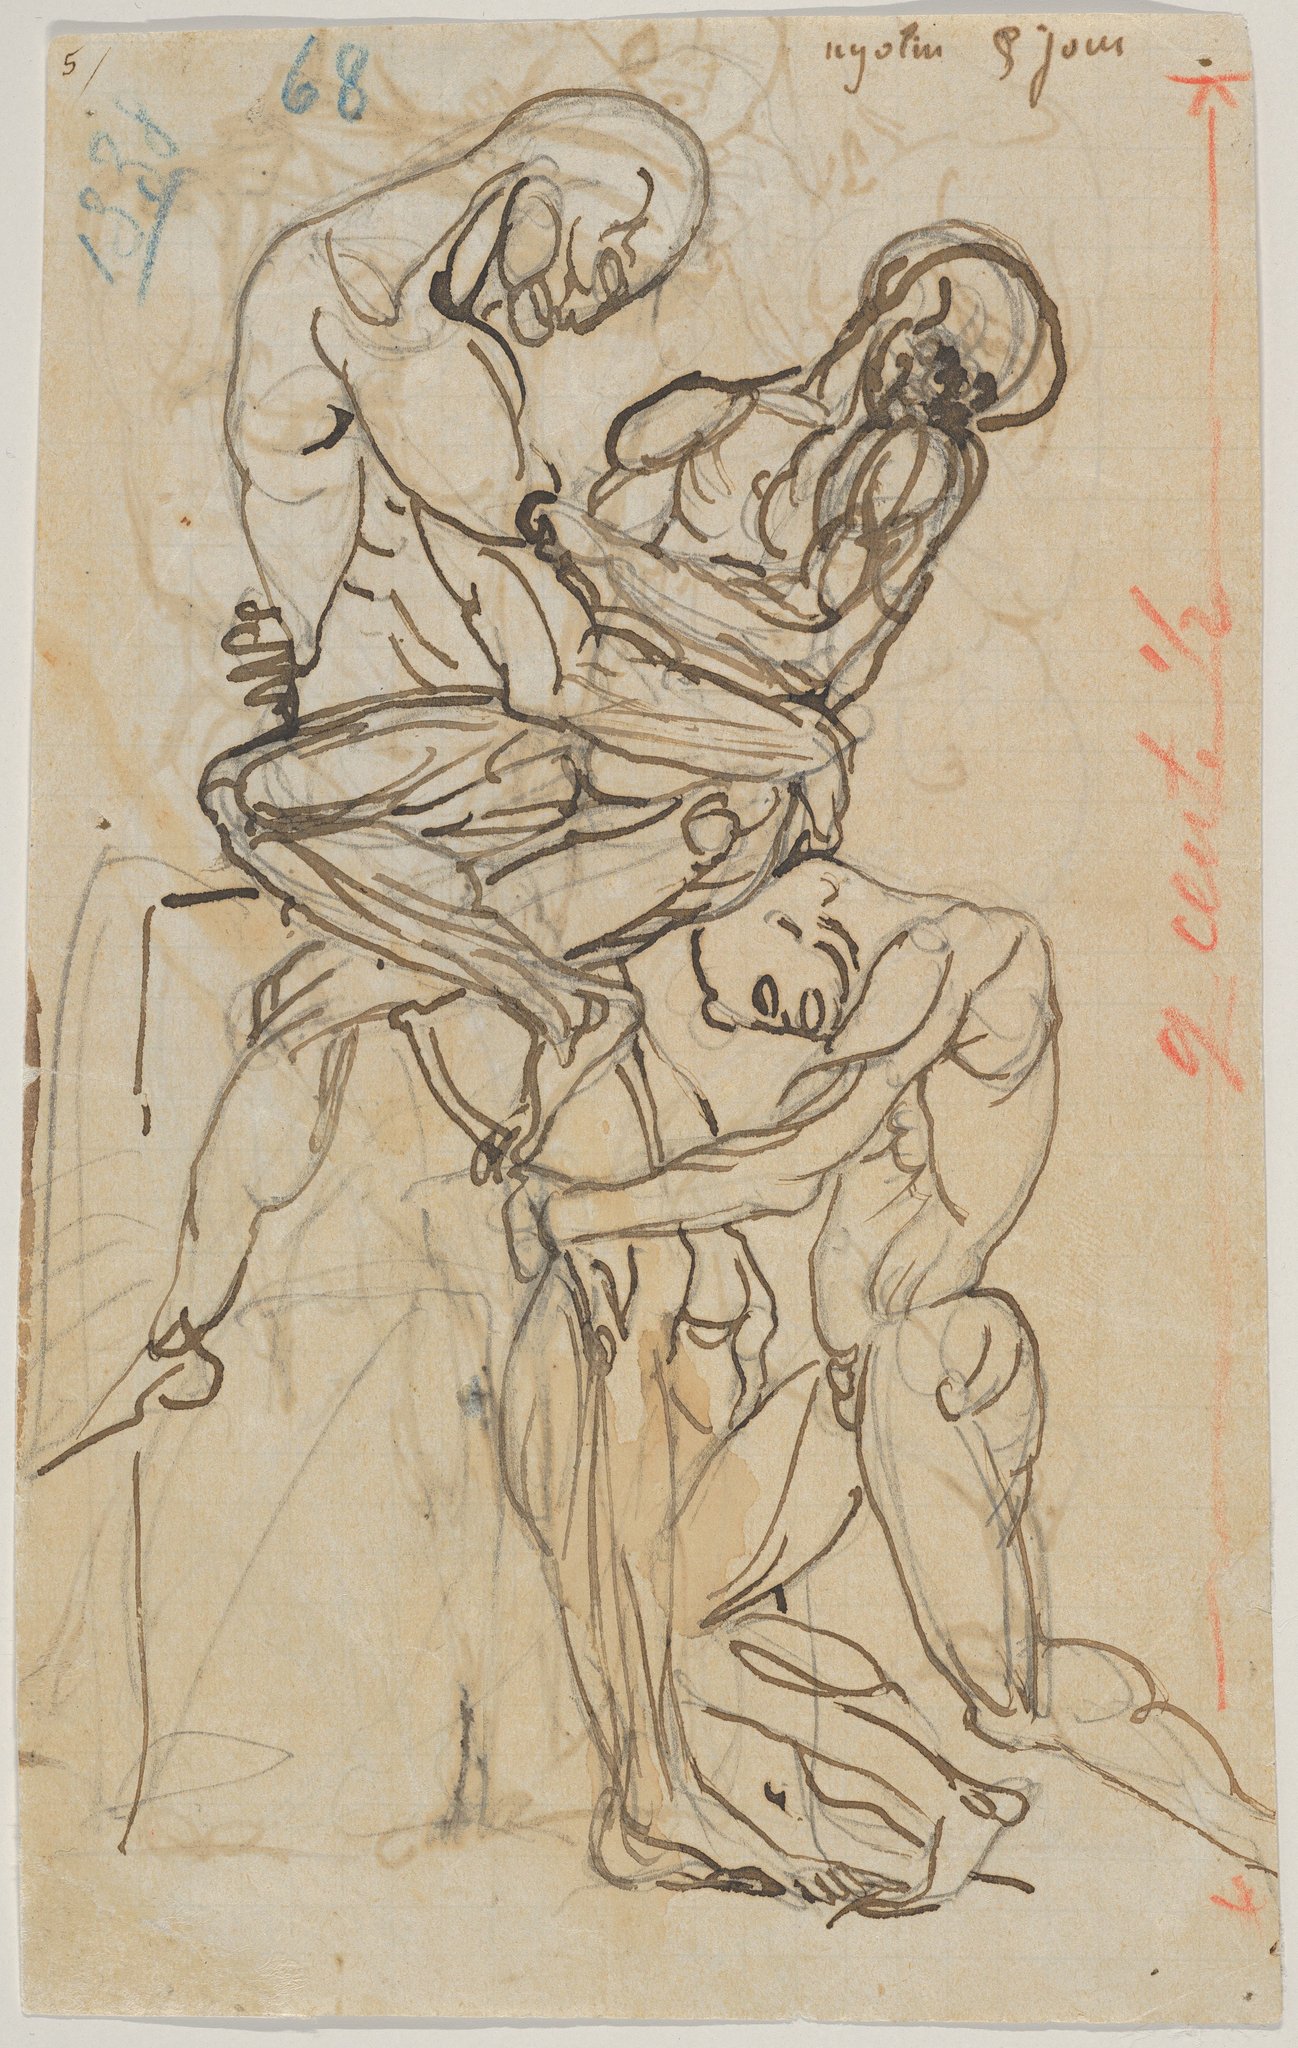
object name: drawing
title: Ugolino and his Sons: Fifth Day (recto); Dante and Virgil: Anatomical Studies (verso)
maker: auguste rodin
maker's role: artist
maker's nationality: french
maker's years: 1840-1917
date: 1875-1880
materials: graphite, ink, paper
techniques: pen, wash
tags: male nudes,fathers